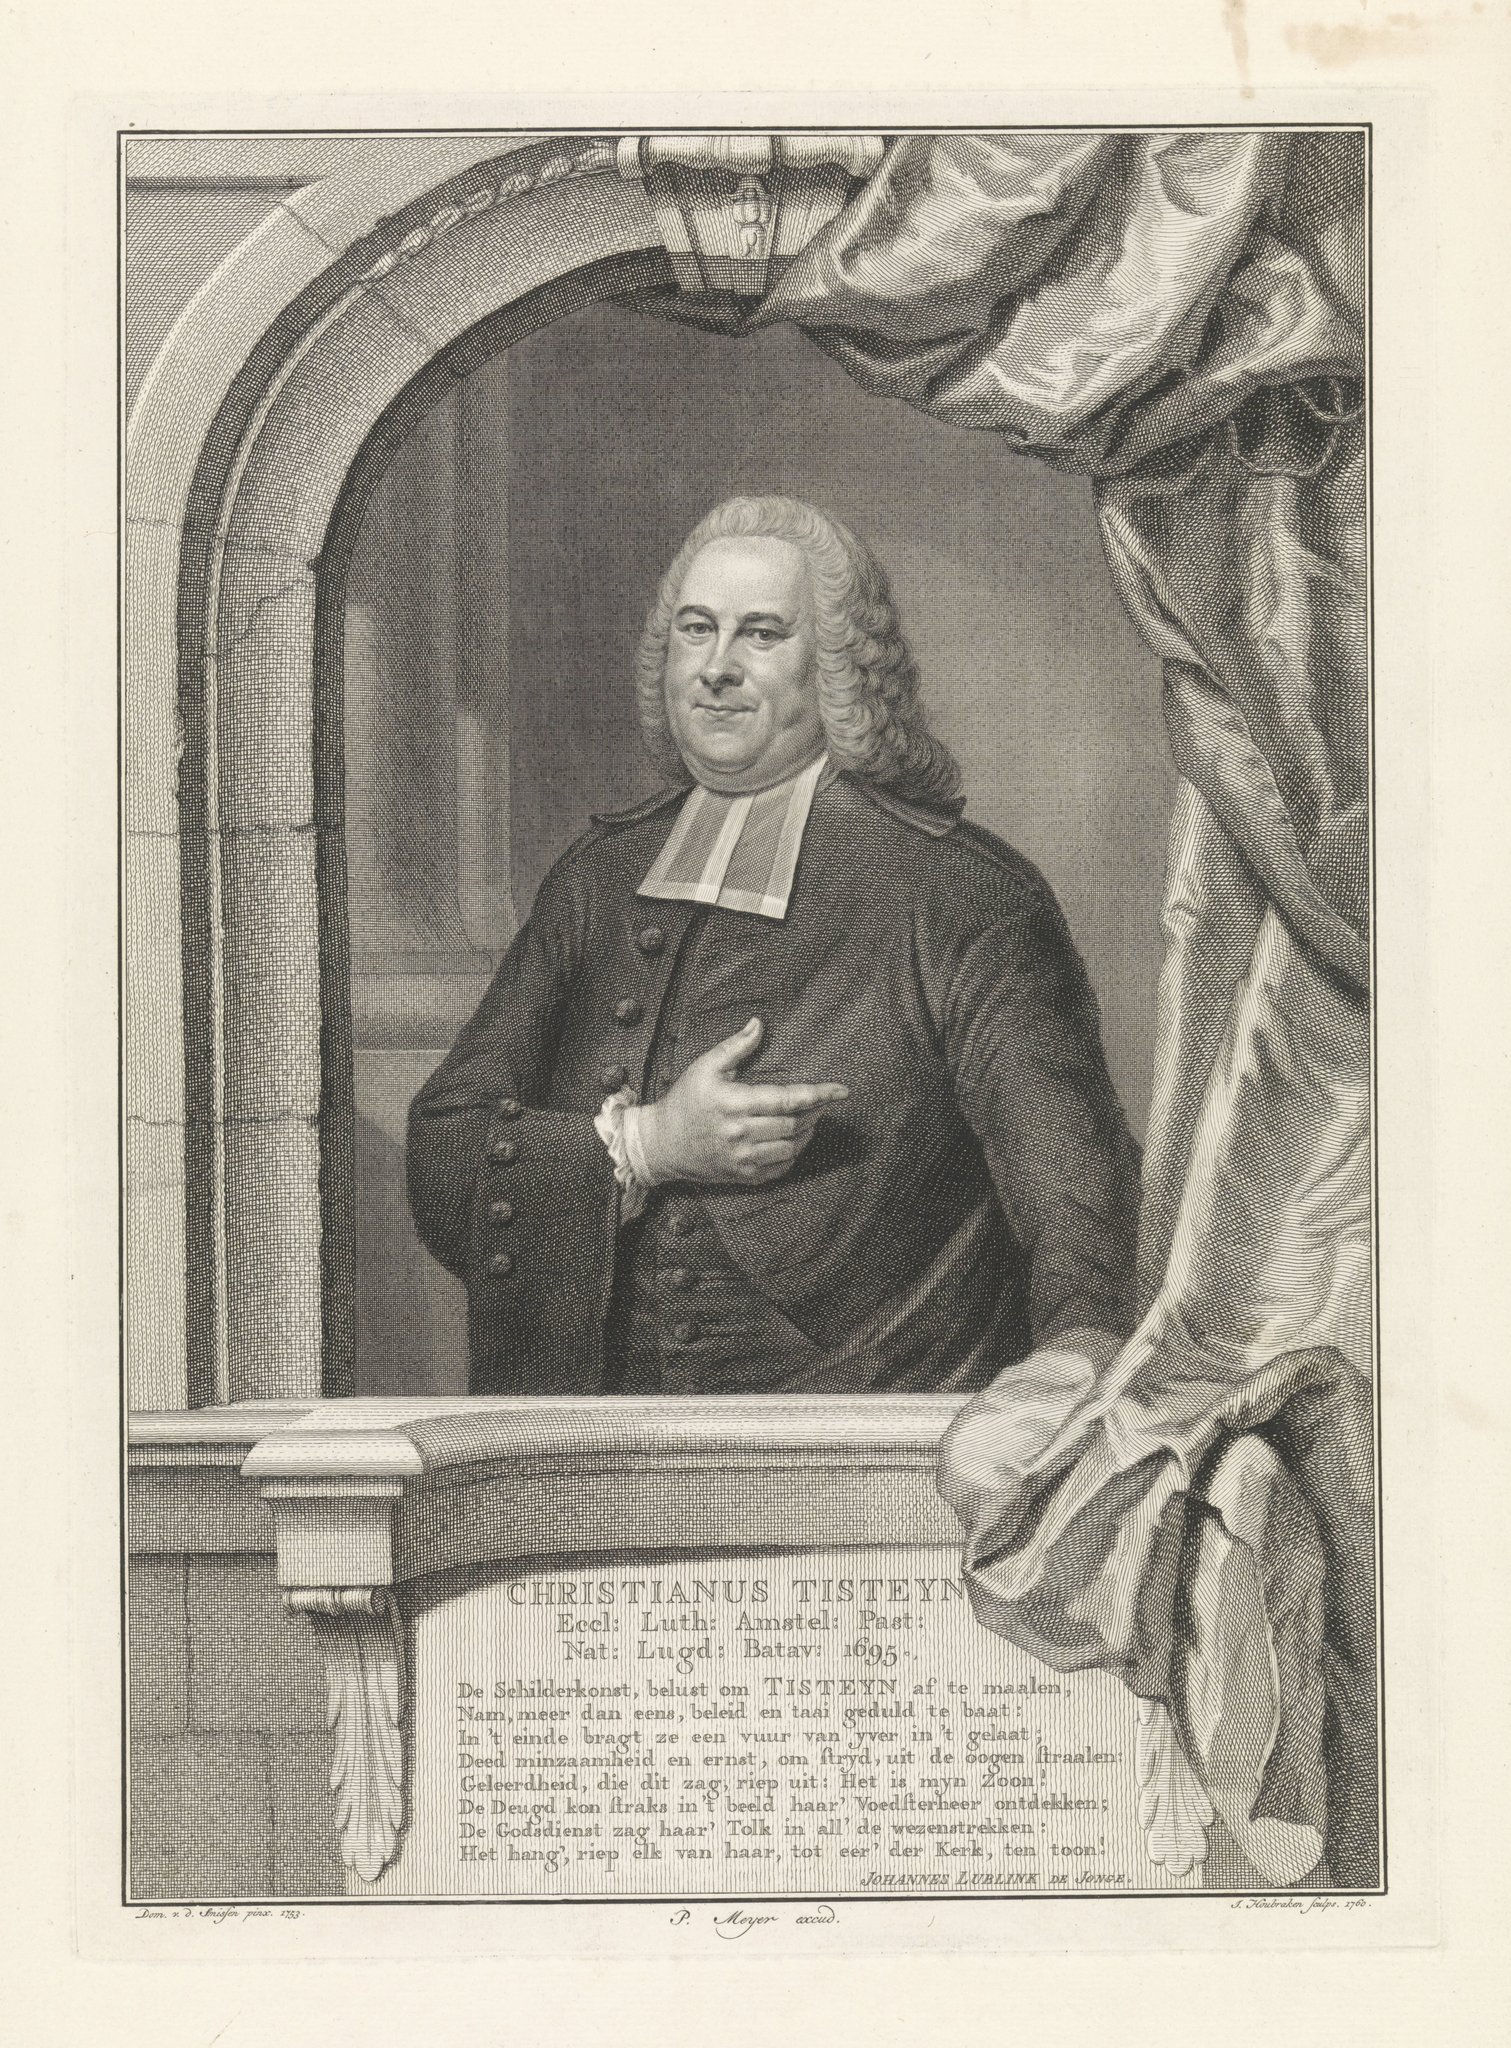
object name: print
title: Christianus Tisteyn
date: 1760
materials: paper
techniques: engraving, etching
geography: amsterdam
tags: leiden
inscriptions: collector's mark: Lugt 2228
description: Portret ten halven lijve naar links van Christiaan Tisteijn in een architectonische, venstervormige omlijsting. Rechts een gordijn. Onder de vensterbank zijn naam en gegevens in drie regels in het Latijn en daaronder een achtregelig vers in het Nederlands.